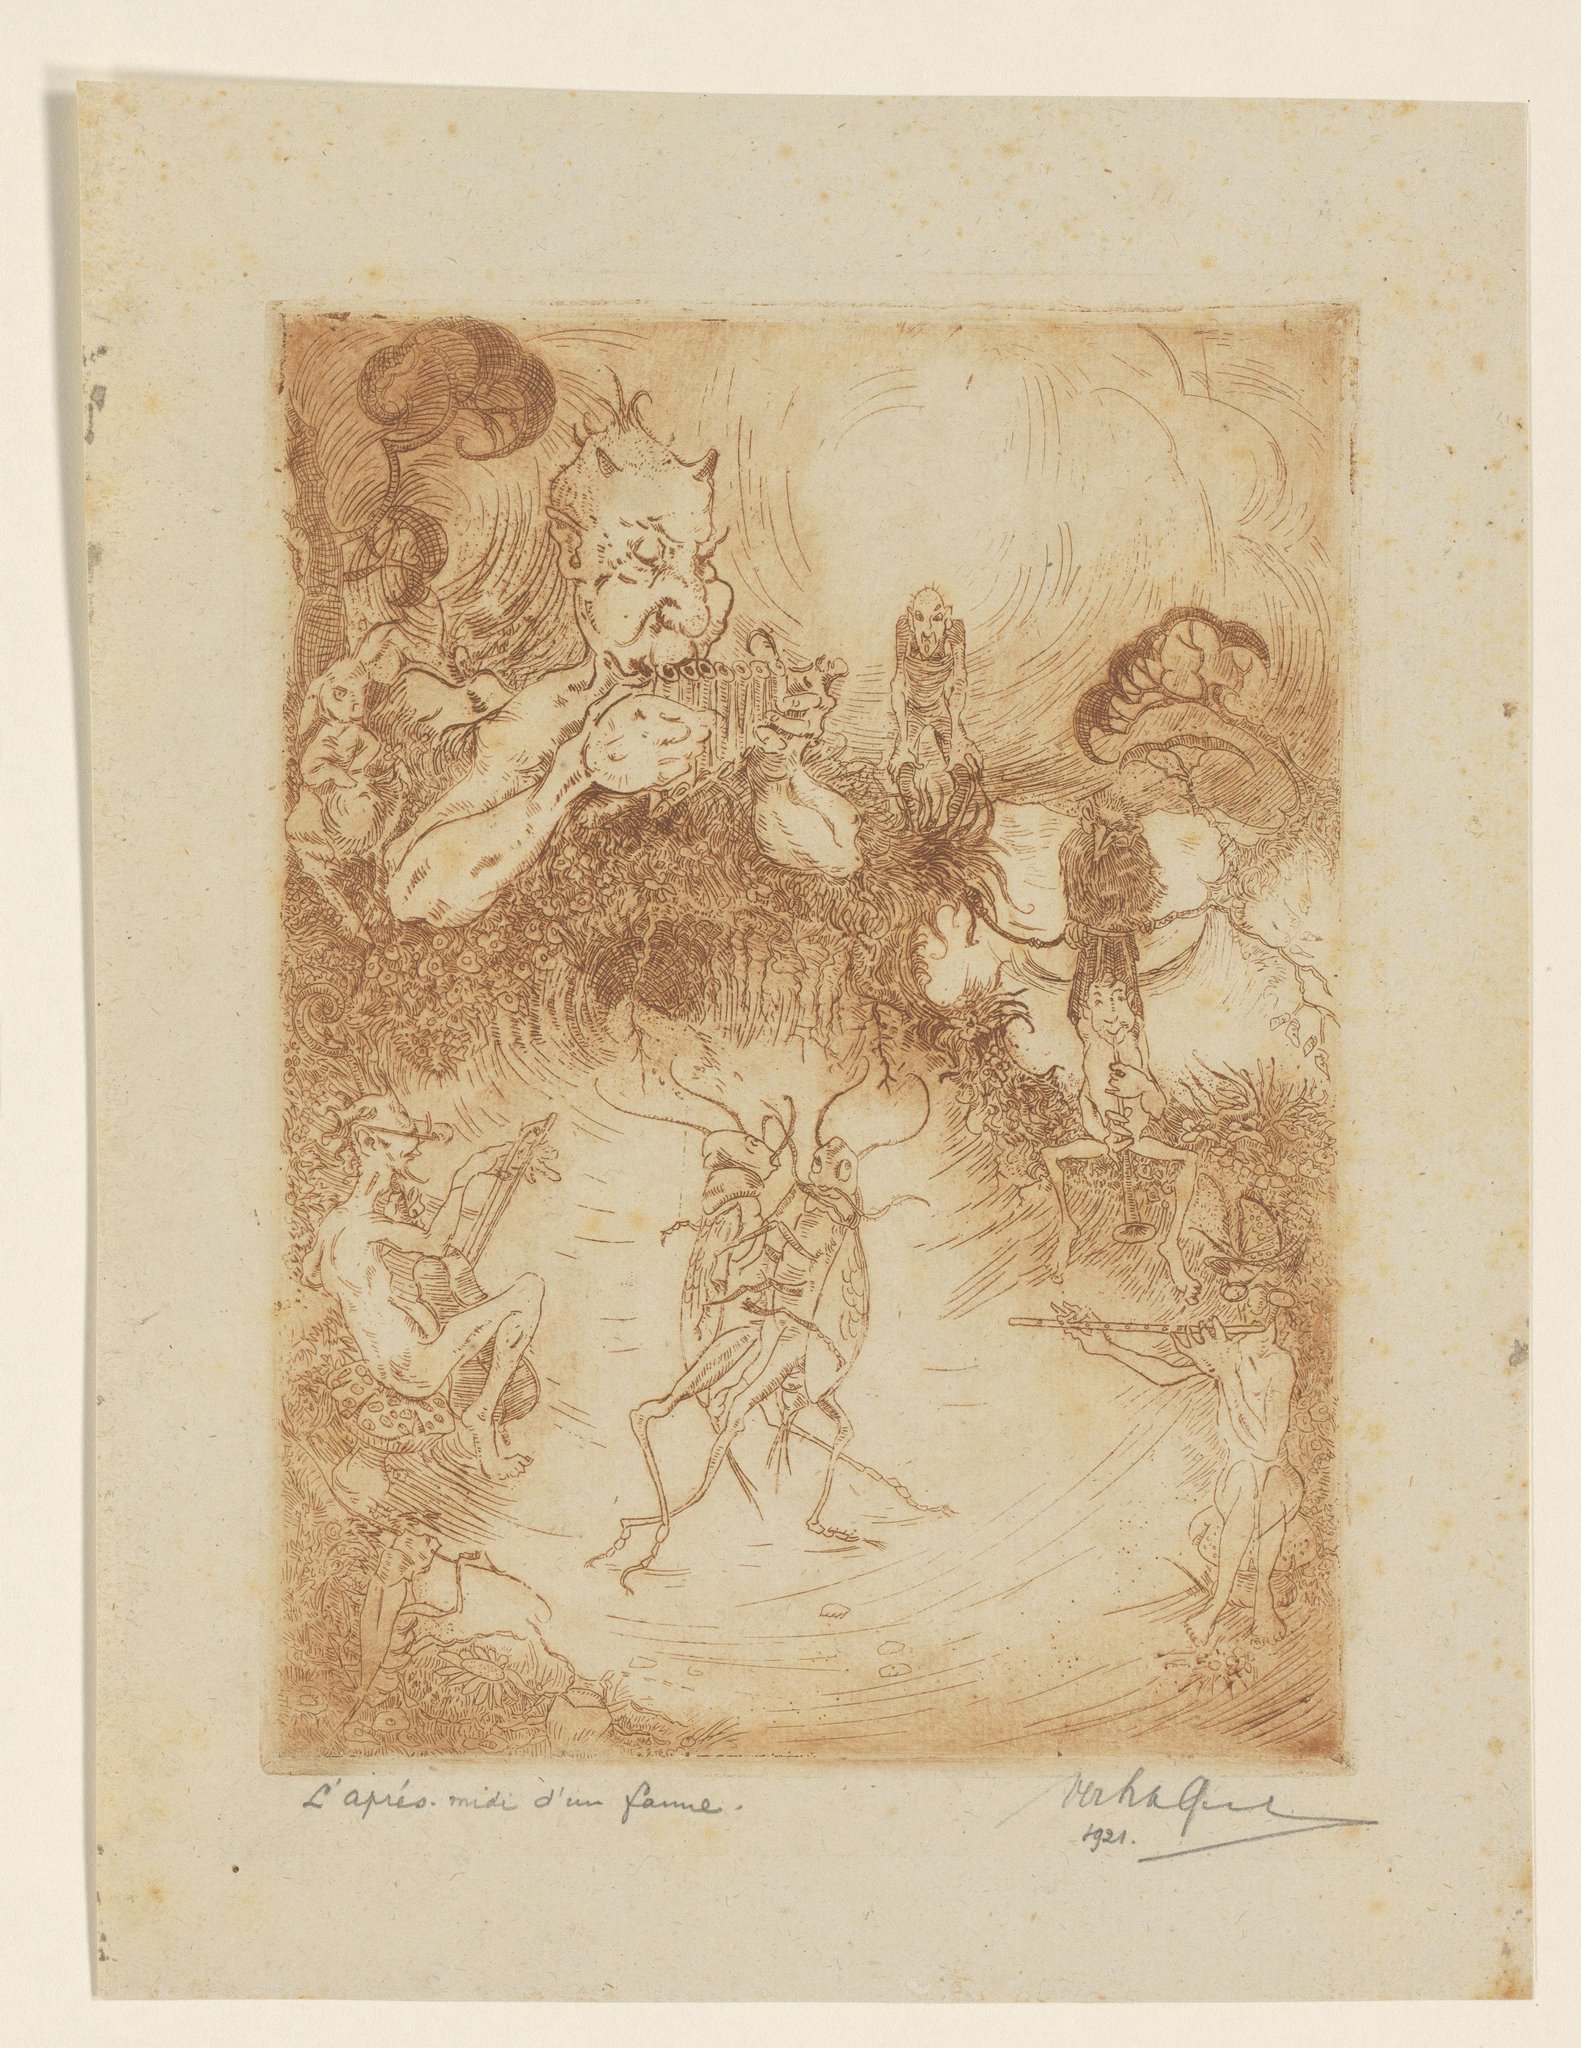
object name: print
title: L'après midi d'un faun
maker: otto verhagen (i)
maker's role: draughtsman, print maker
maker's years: 1885-1951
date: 1921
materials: paper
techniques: etching, intaglio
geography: netherlands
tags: music, dancing, insects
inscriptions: collector's mark: Lugt 2228